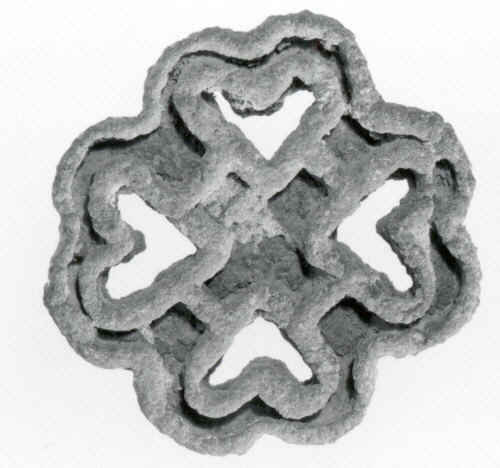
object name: stamp seal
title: Compartmented stamp seal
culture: bactria-margiana archaeological complex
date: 2333-1668 BCE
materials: copper alloy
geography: bactria-margiana